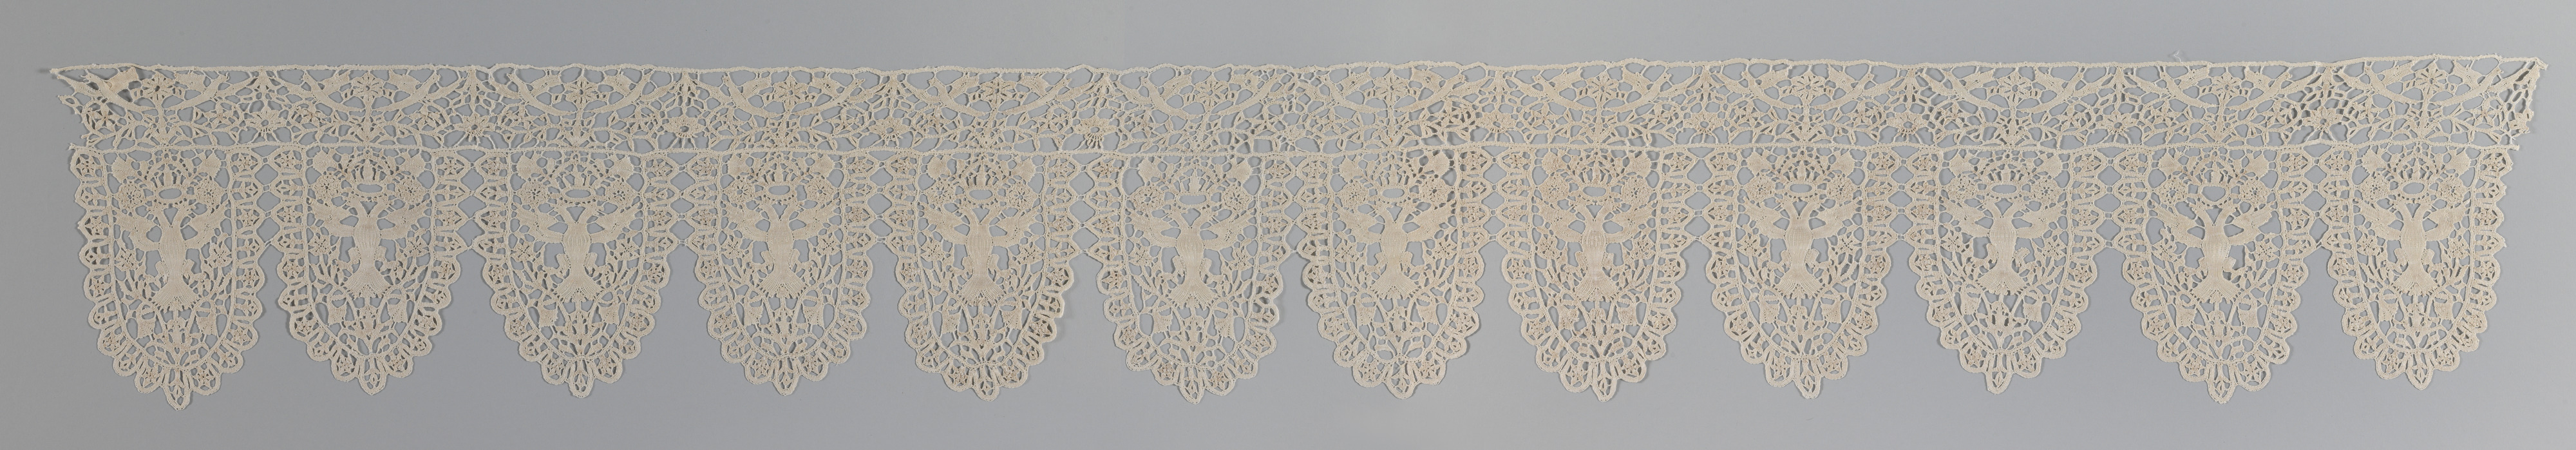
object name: border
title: Lace border with double-headed eagle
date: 1620-1630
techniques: lace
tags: eagles